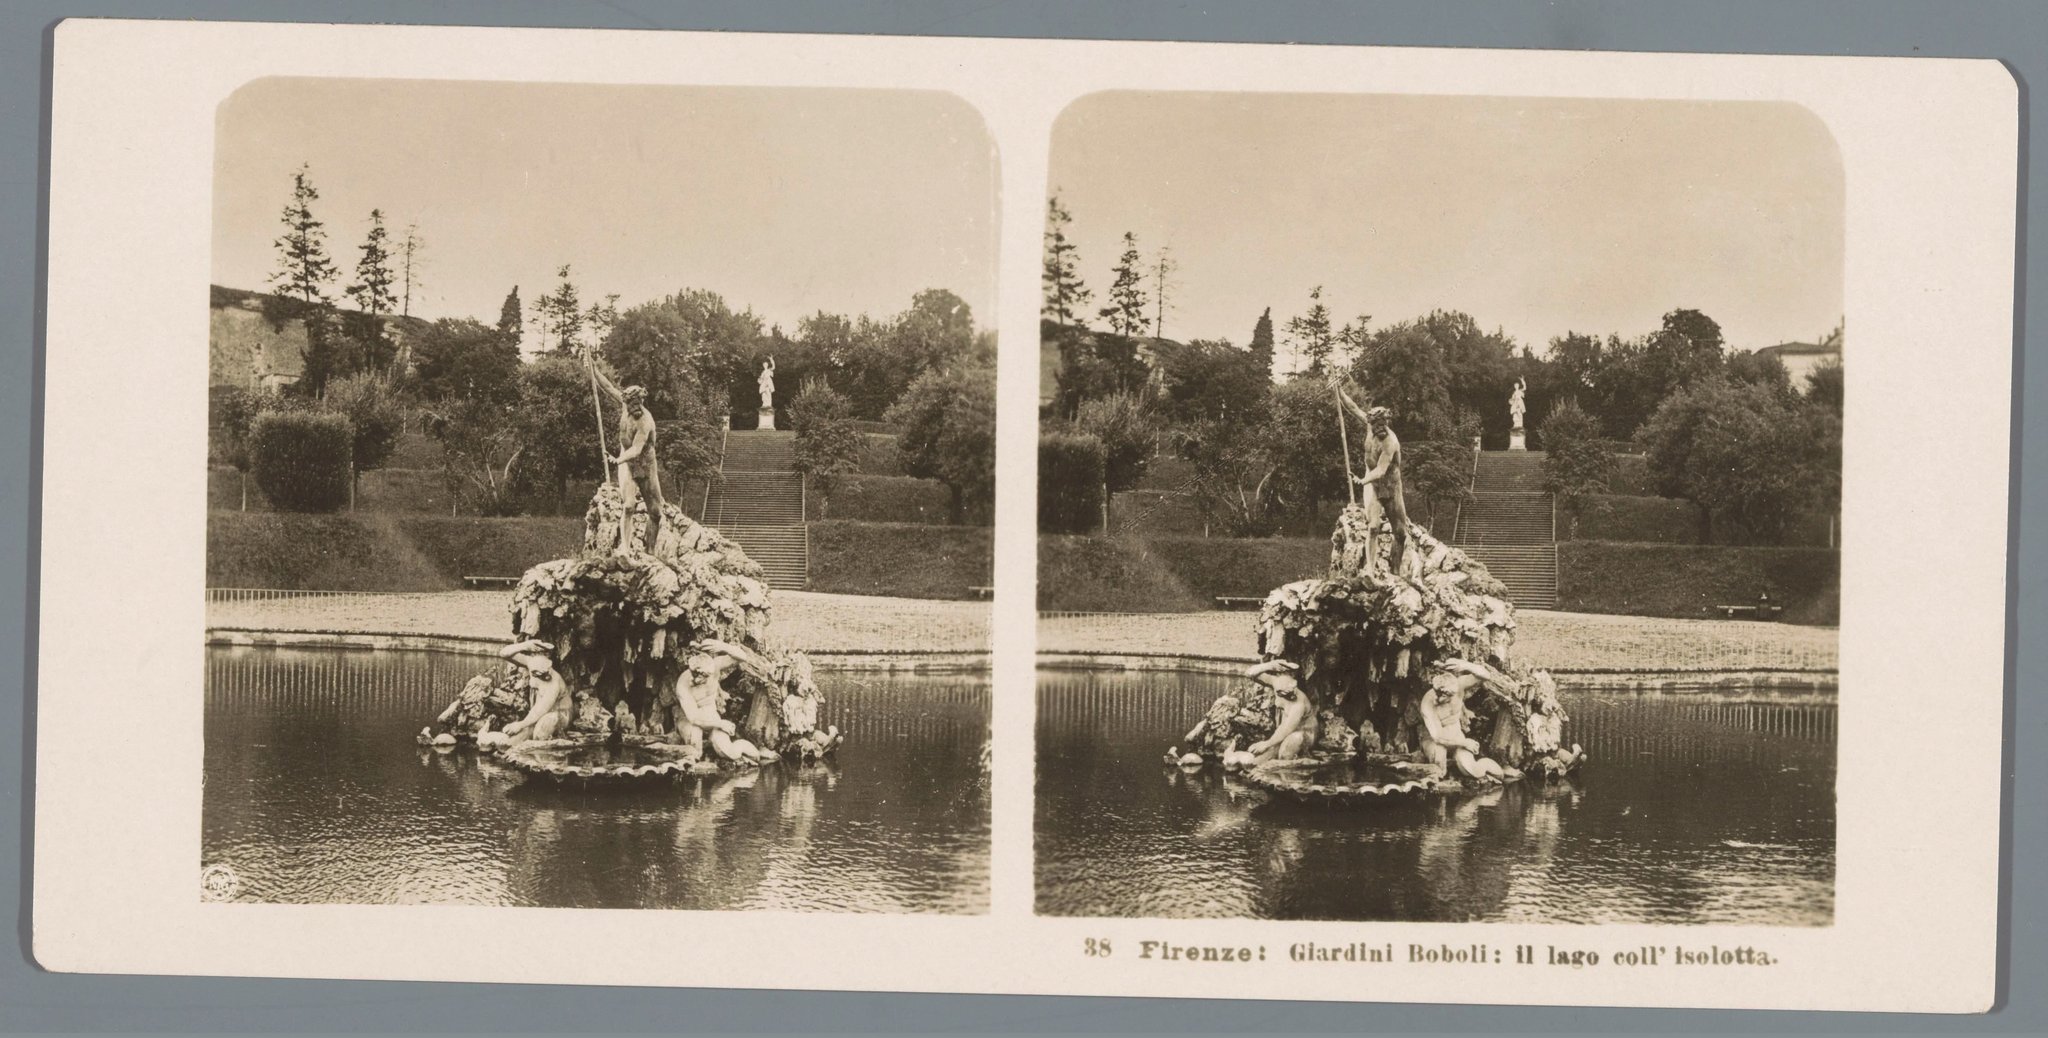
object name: stereograph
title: Sculptuur van Neptunus in de Bobolituinen te Florence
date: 1900-1910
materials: cardboard, photographic support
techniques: gelatin silver print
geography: giardino di boboli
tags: (story of) neptune (poseidon), garden, sculpture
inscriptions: number: ‘38’, inscription: ‘NPG’